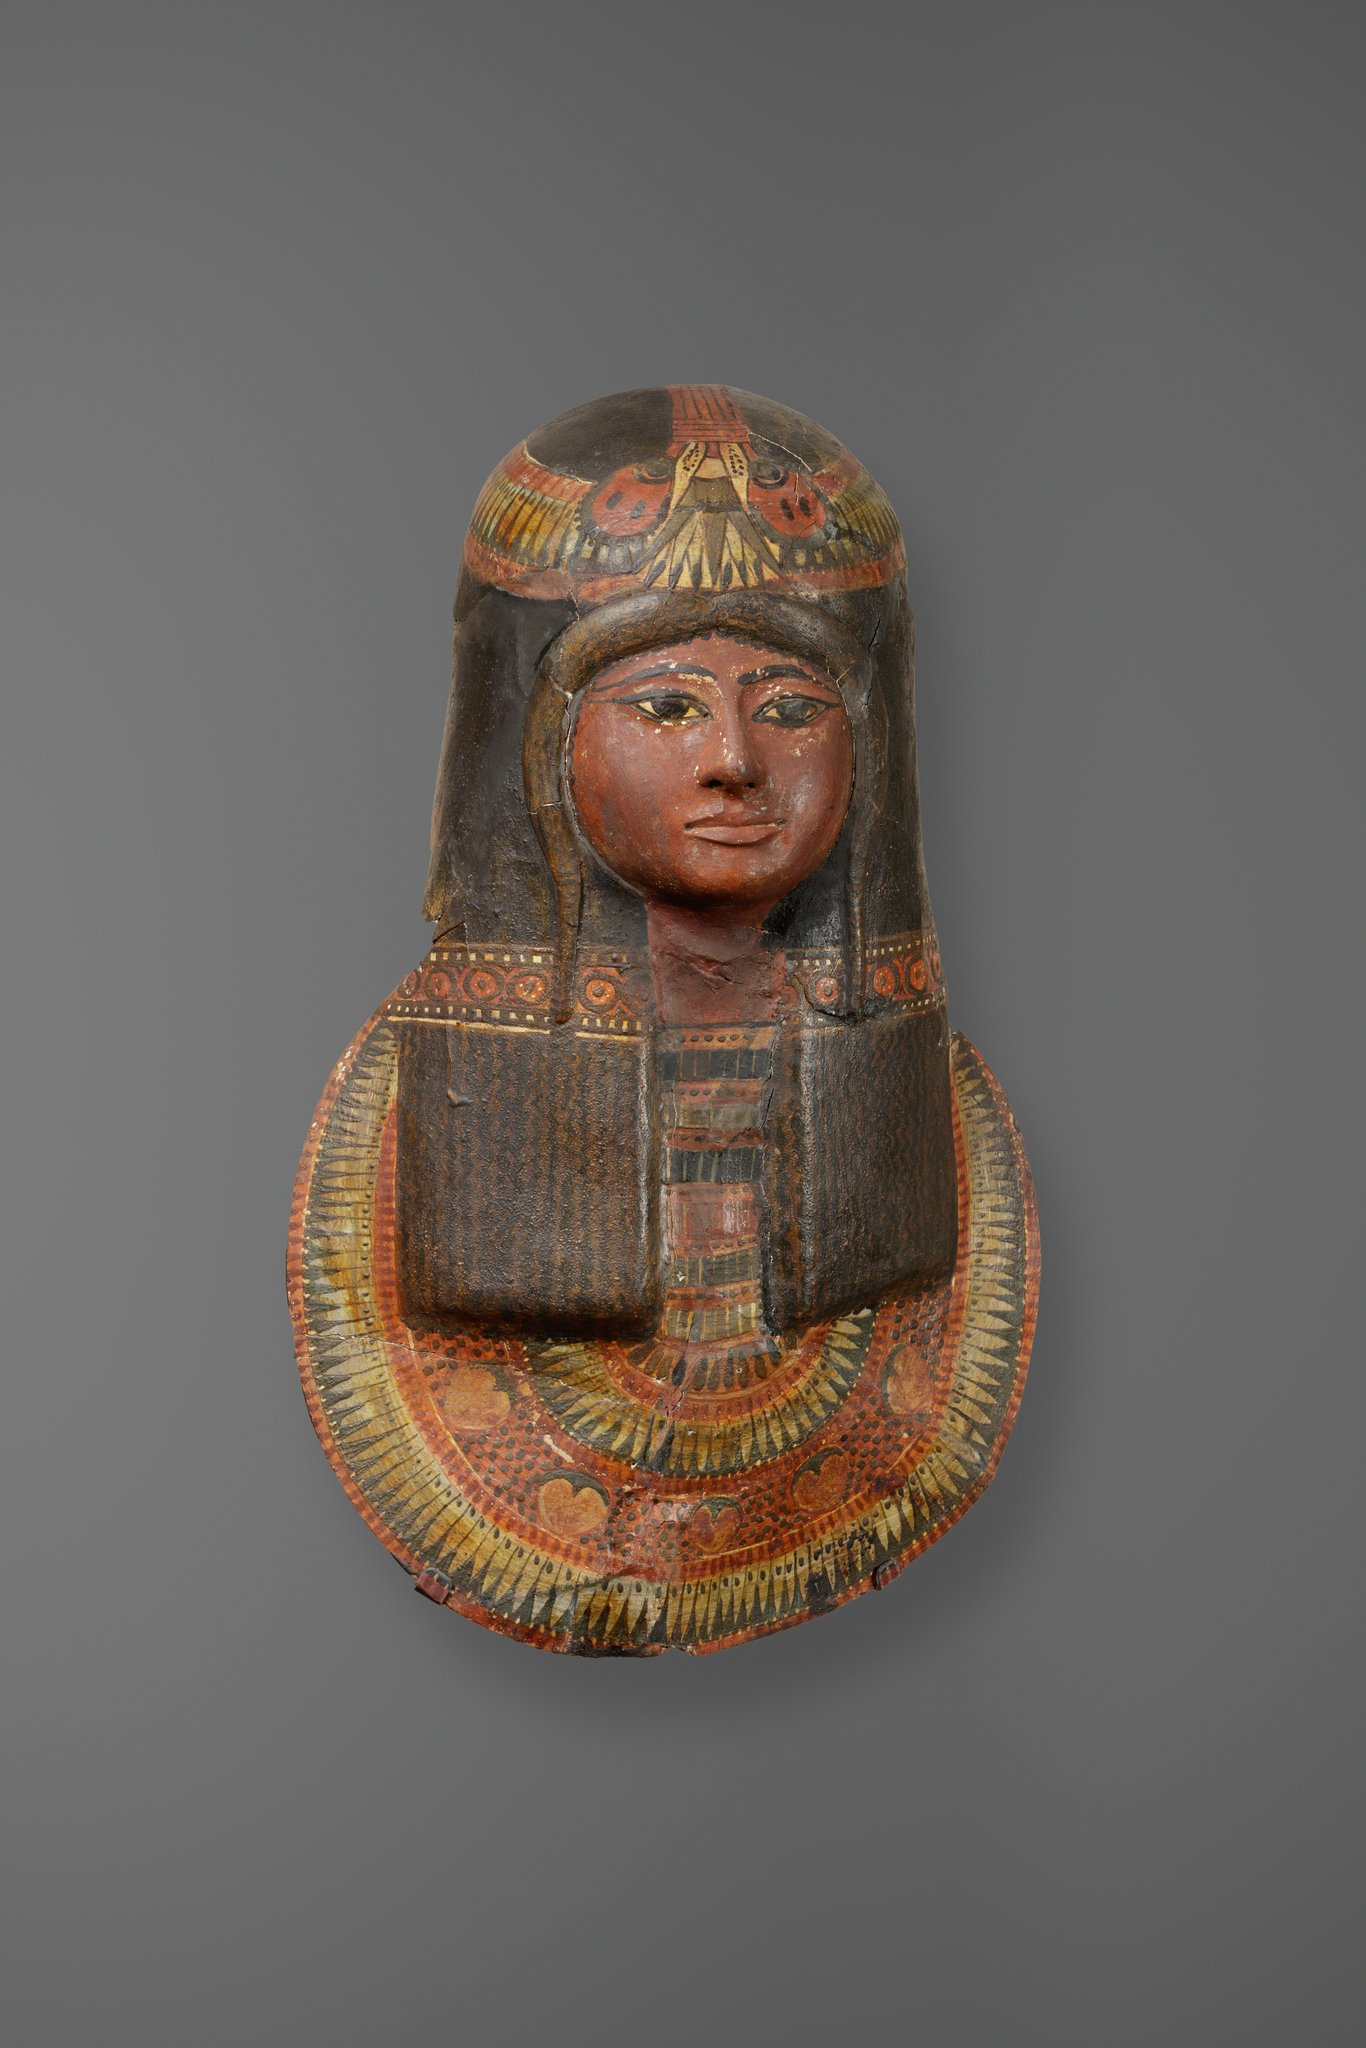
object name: mask, iineferty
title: Mask of Iineferty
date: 1279-1213 BCE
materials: paint, paste, wood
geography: egypt